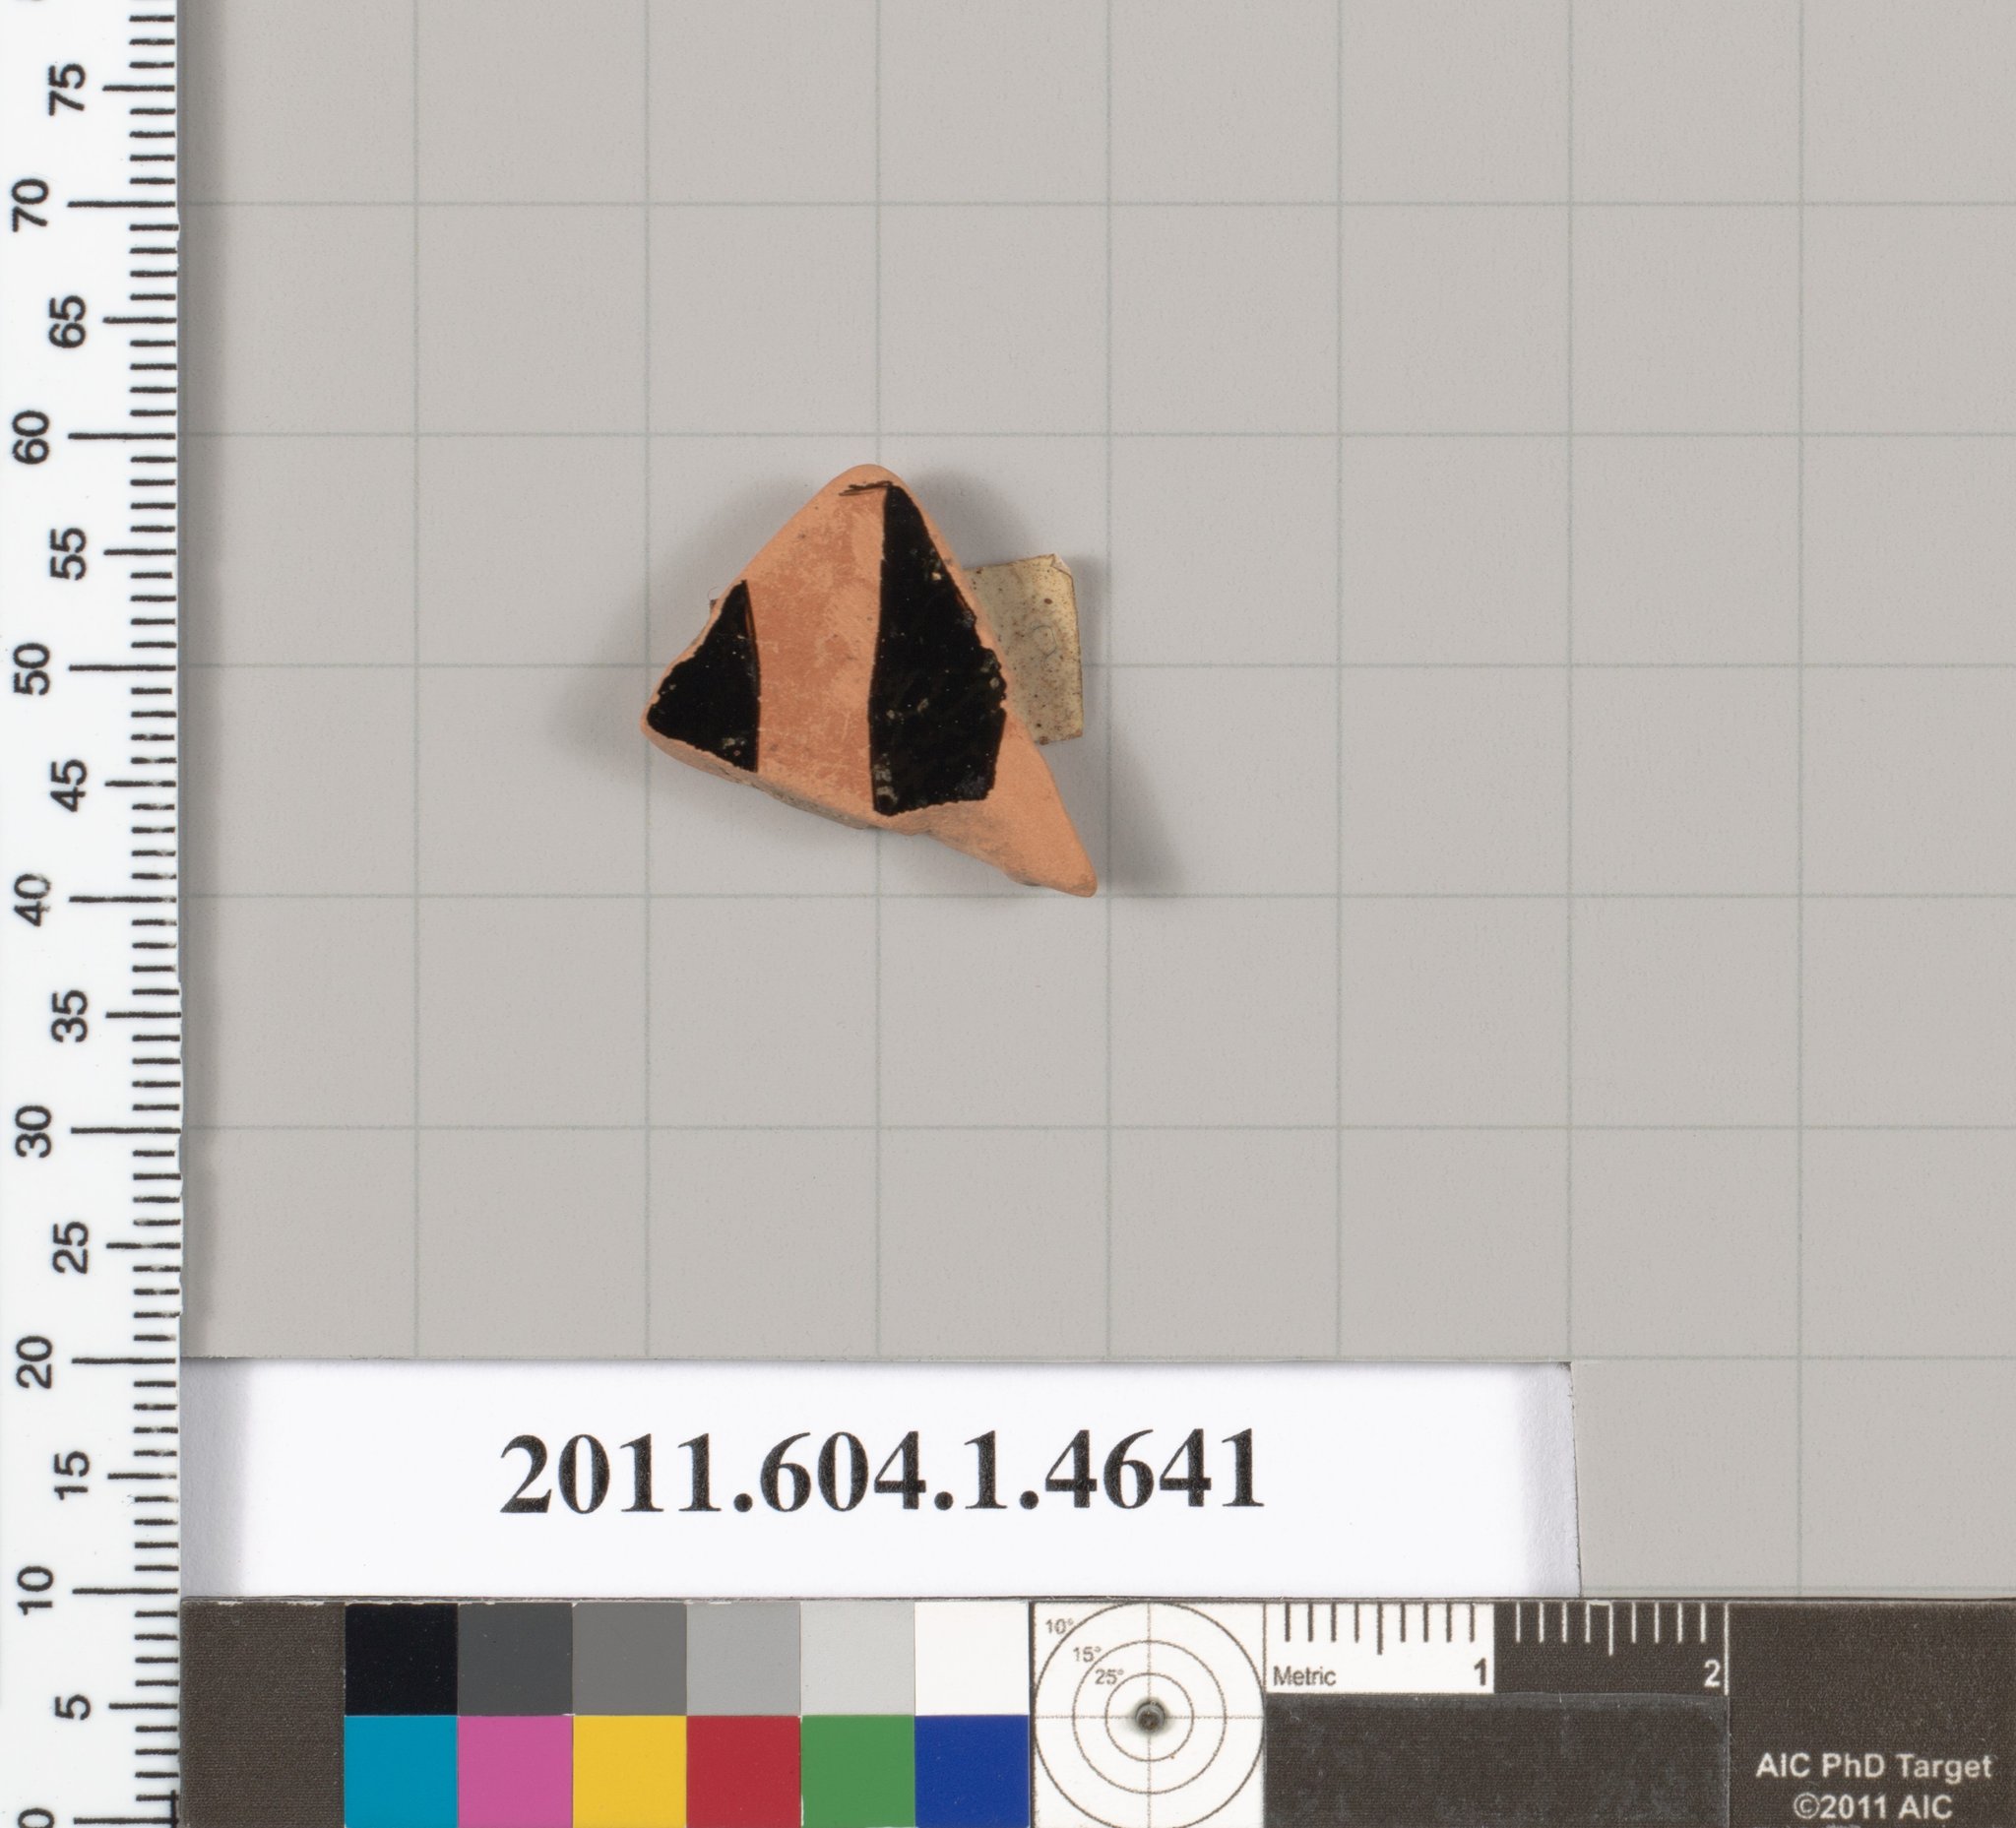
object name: kylix fragment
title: Terracotta fragment of a kylix (drinking cup)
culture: greek, attic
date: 475-451 BCE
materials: terracotta